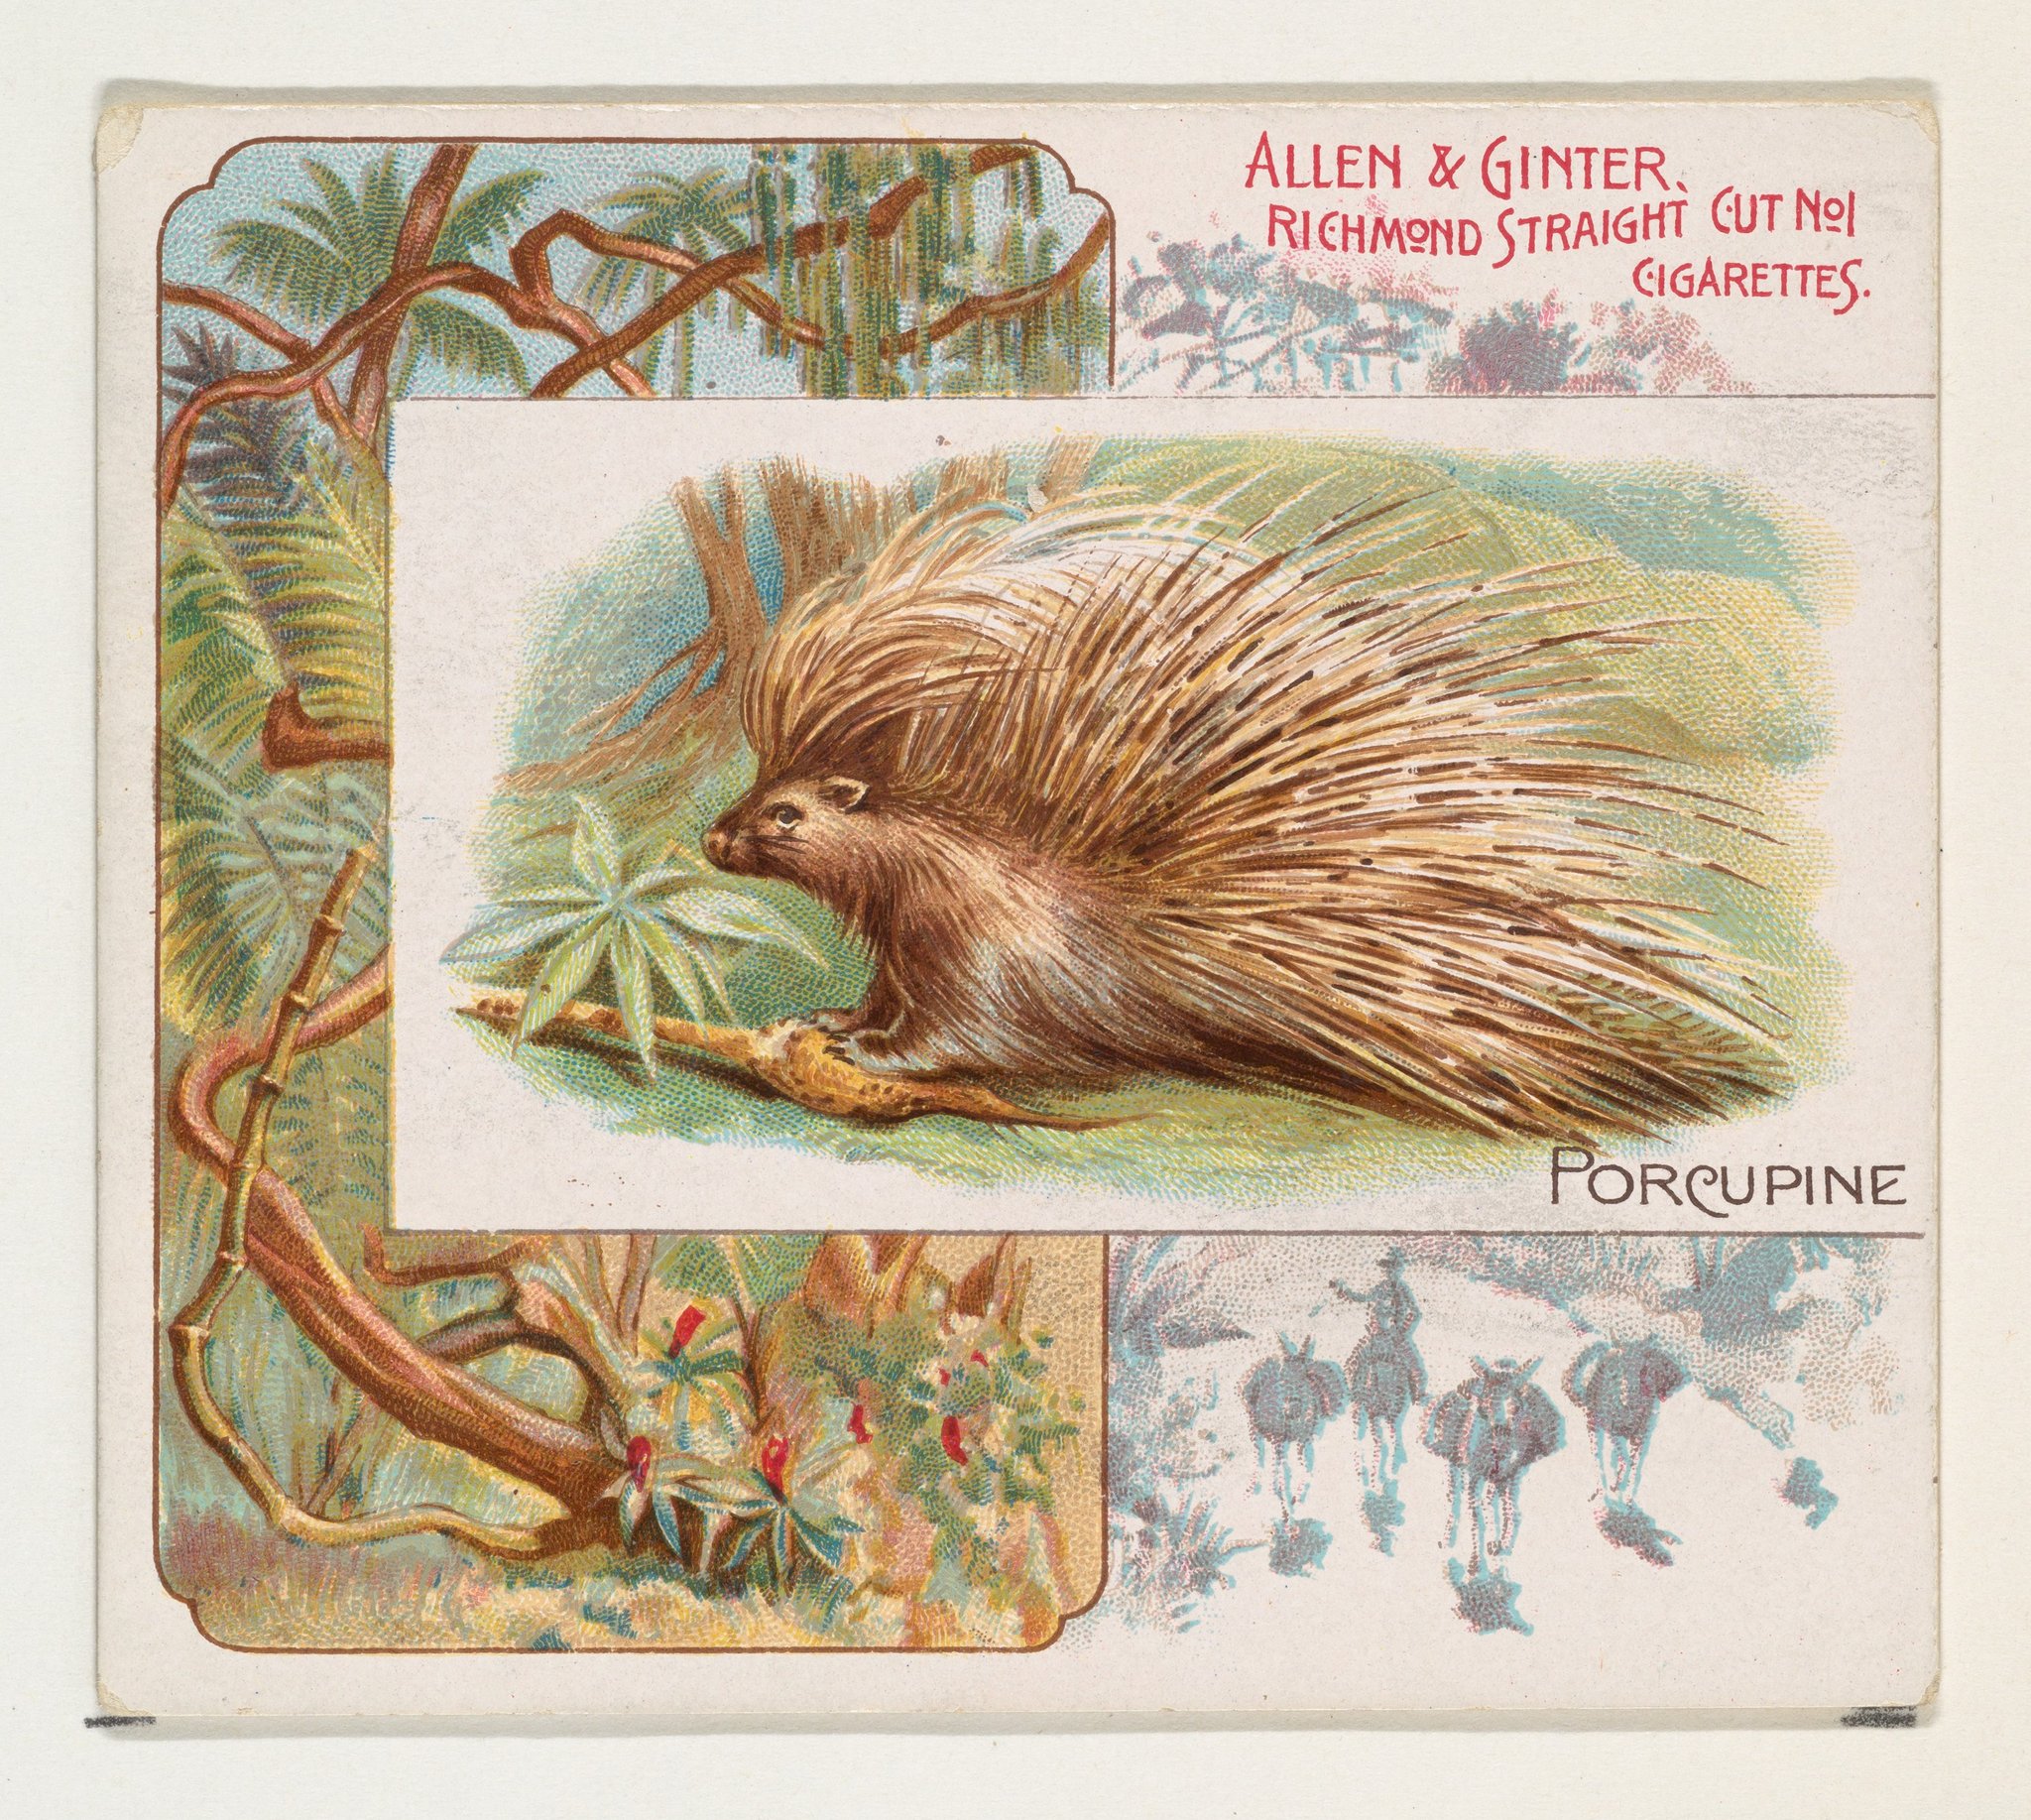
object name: print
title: Porcupine, from Quadrupeds series (N41) for Allen & Ginter Cigarettes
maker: allen & ginter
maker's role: publisher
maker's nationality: american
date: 1890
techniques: color lithograph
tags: animals